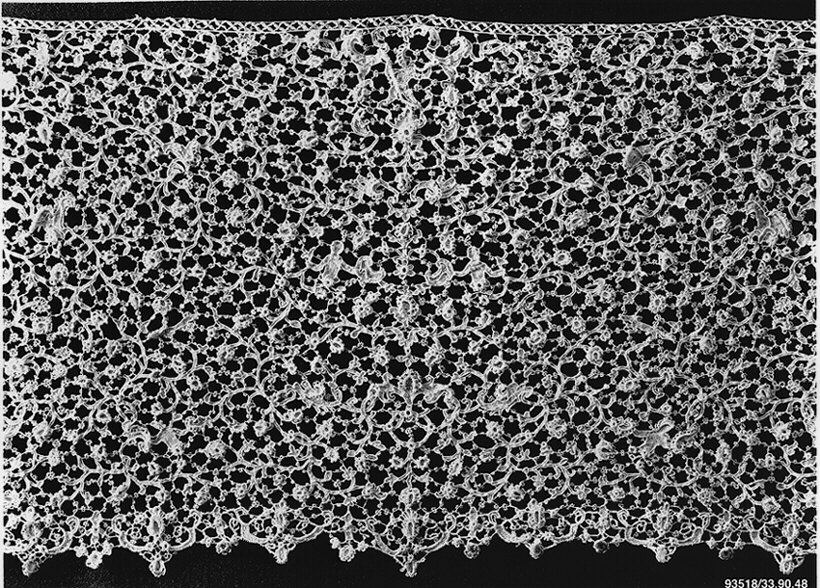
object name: flounce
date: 1601-1700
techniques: lace